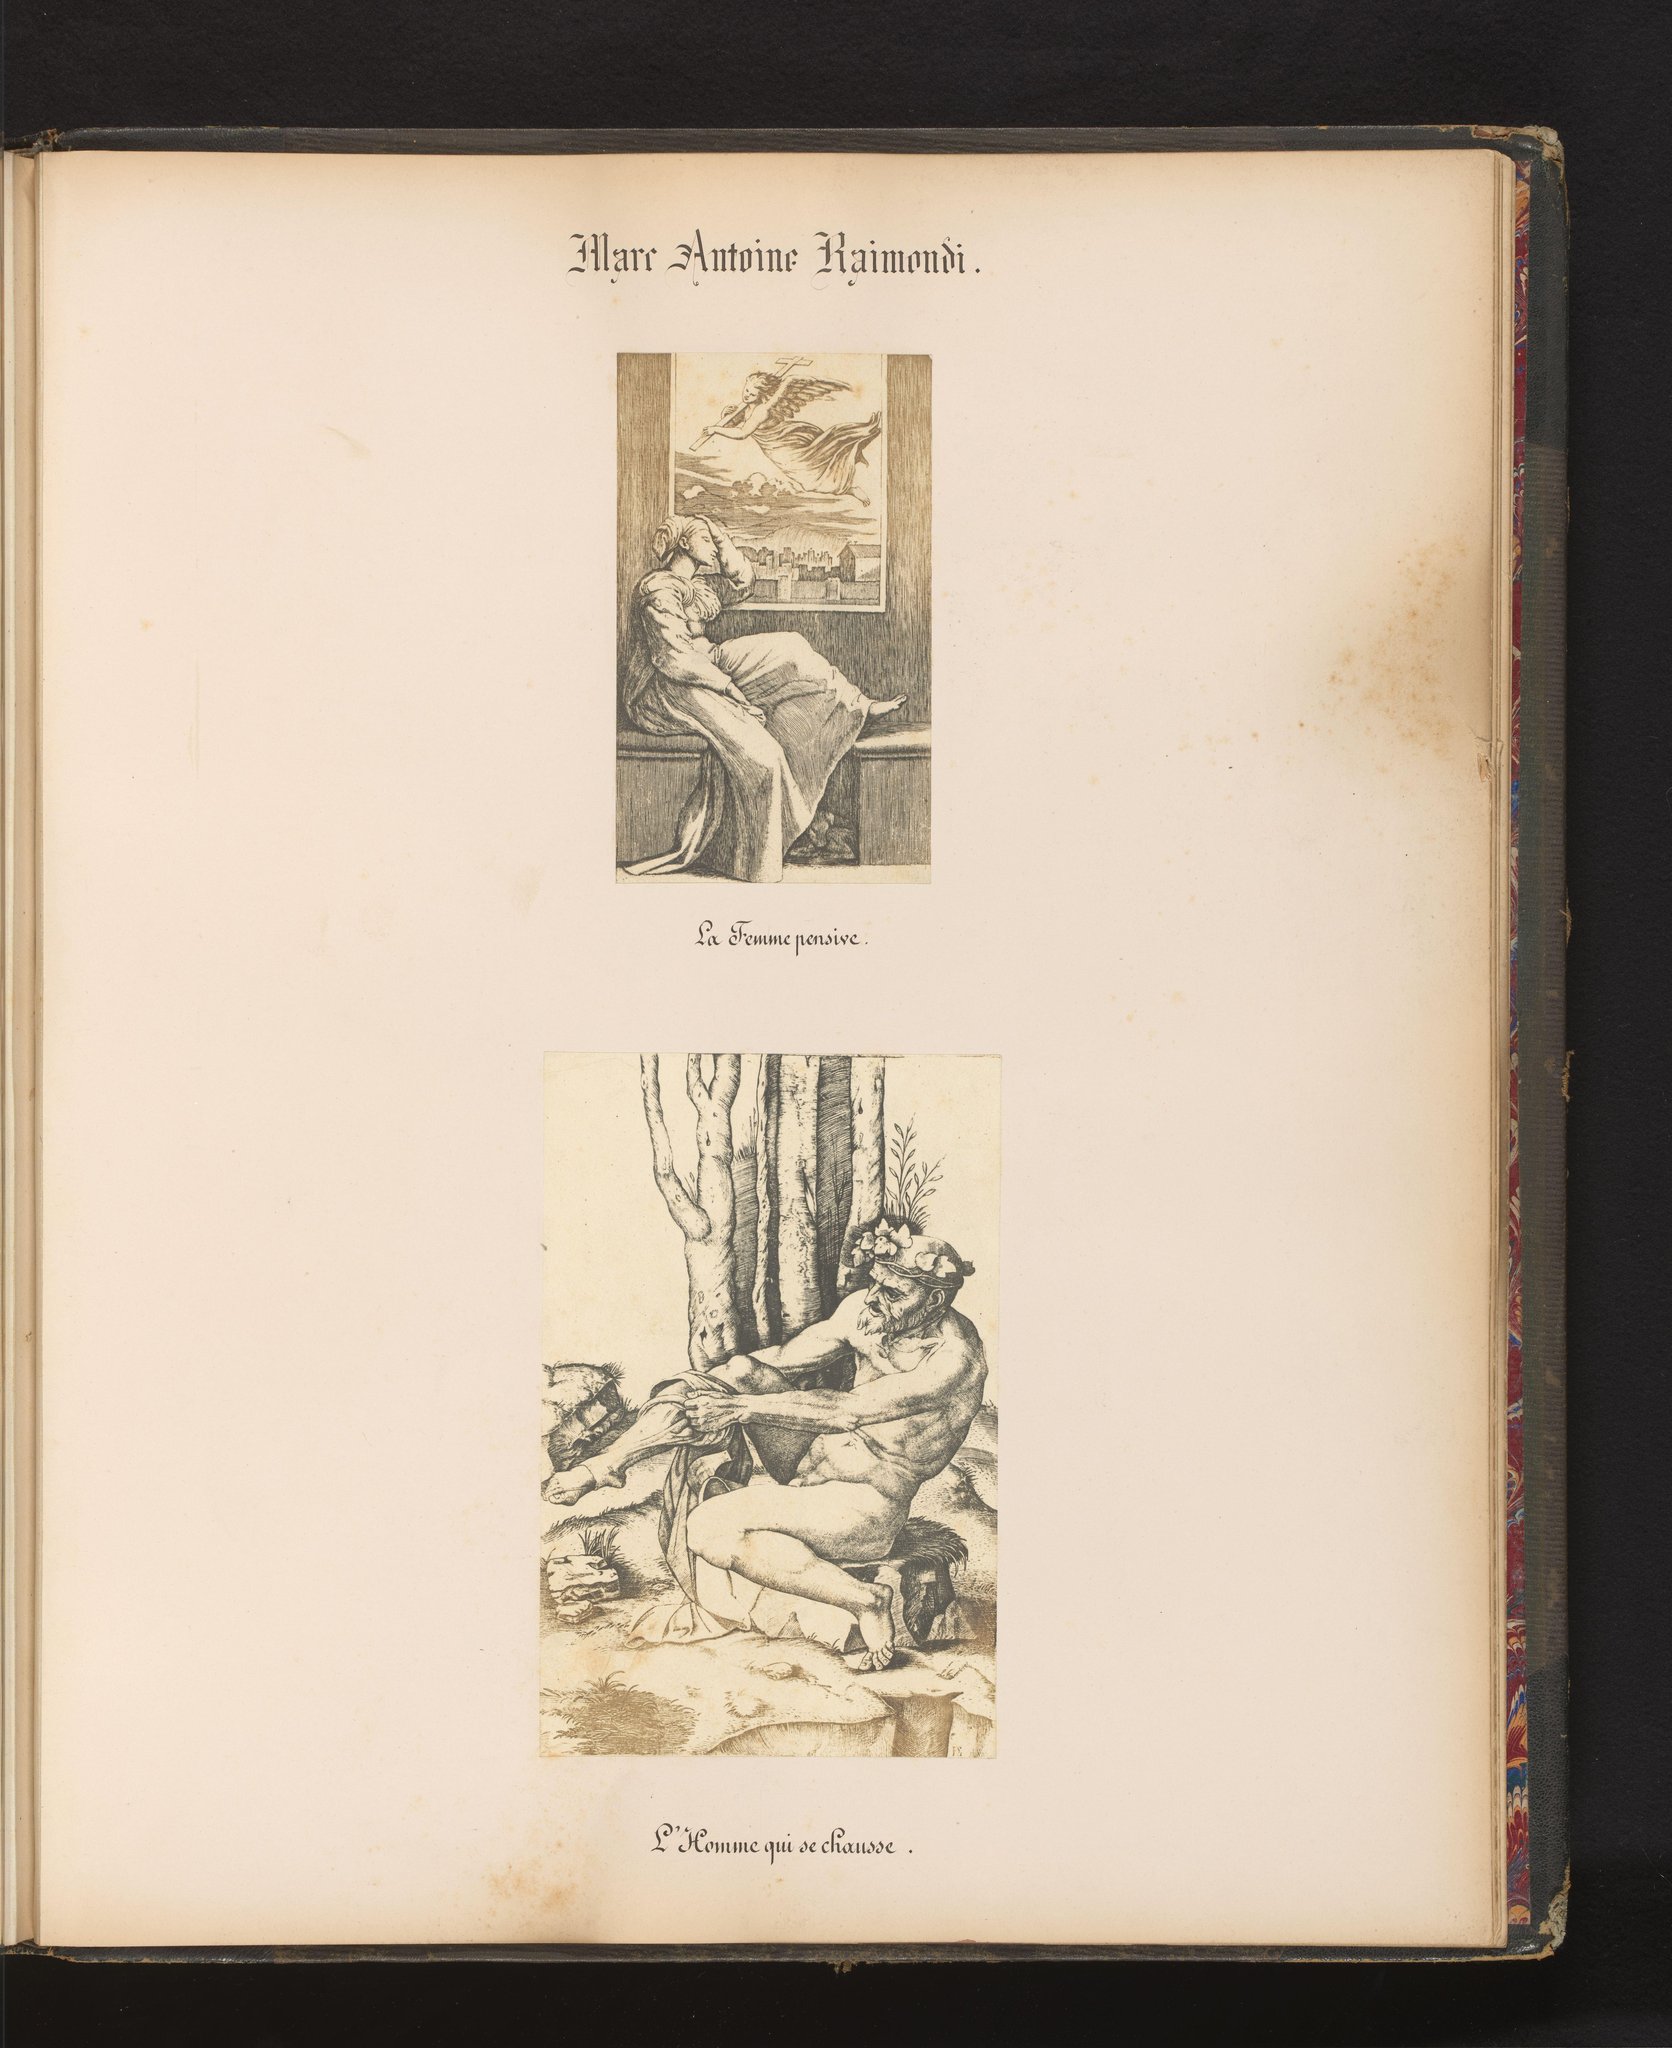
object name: photograph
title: Fotoreproductie van een gravure van man die zich aankleedt door Marcantonio Raimondi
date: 1848-1853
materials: photographic support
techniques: salted paper print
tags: dressing oneself, getting dressed